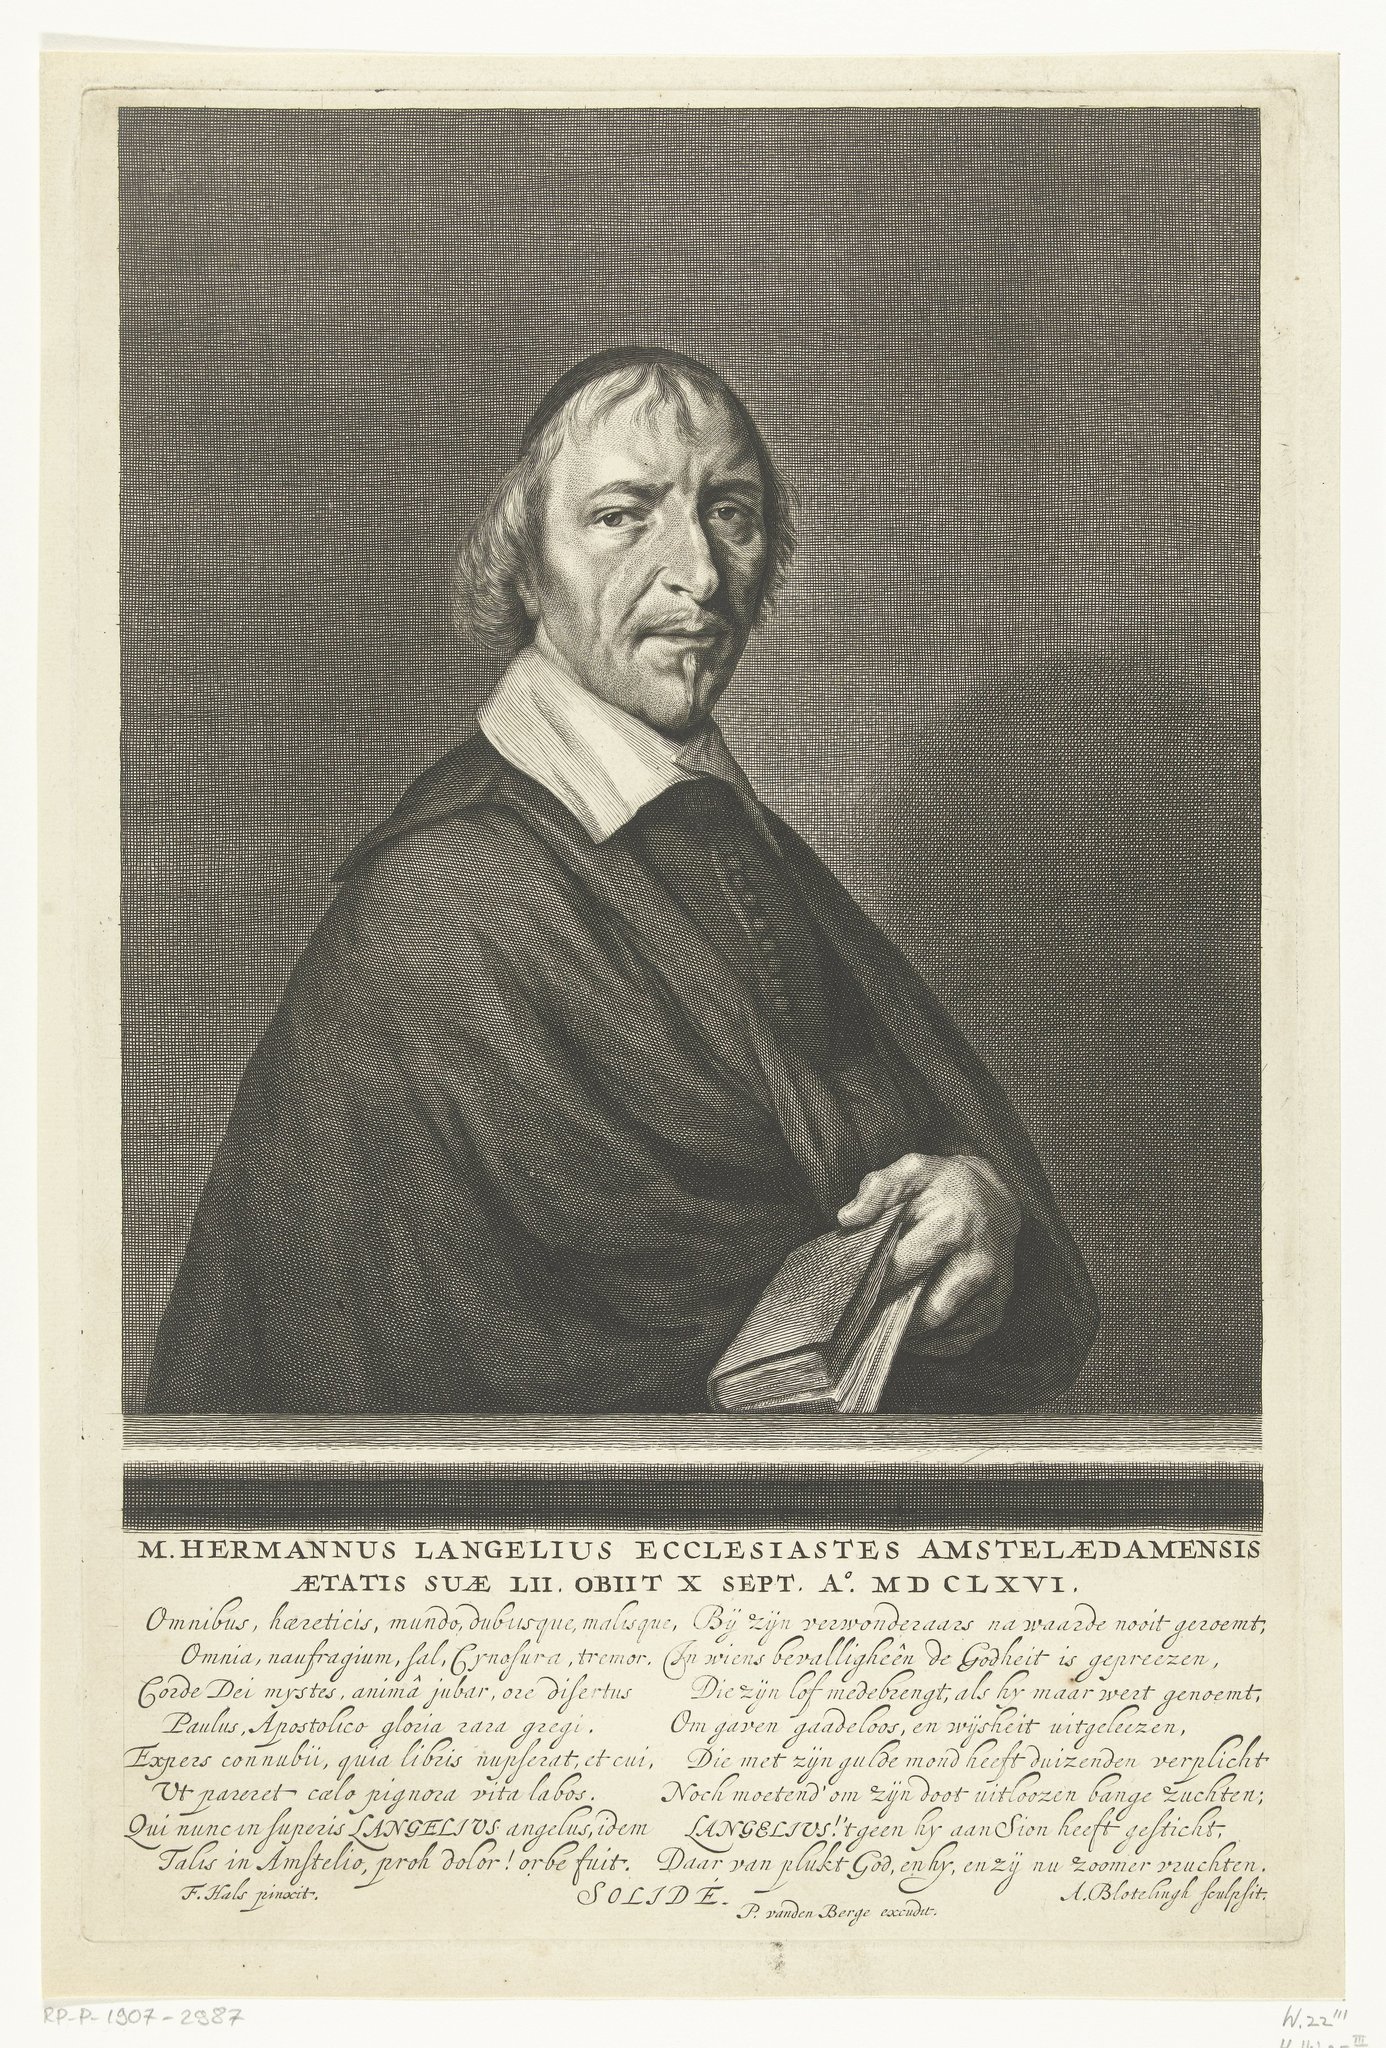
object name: print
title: Portret van Hermanus Langelius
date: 1655-1690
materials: paper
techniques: engraving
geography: amsterdam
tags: predikant, hermanus langelius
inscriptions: collector's mark: Lugt 2166, collector's mark: Lugt 2228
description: Portret van de Amsterdamse predikant Hermanus Langelius, met een boek in zijn hand. Onder het portret een vers in het Latijn en Nederlands op Langelius werk in Amsterdam.